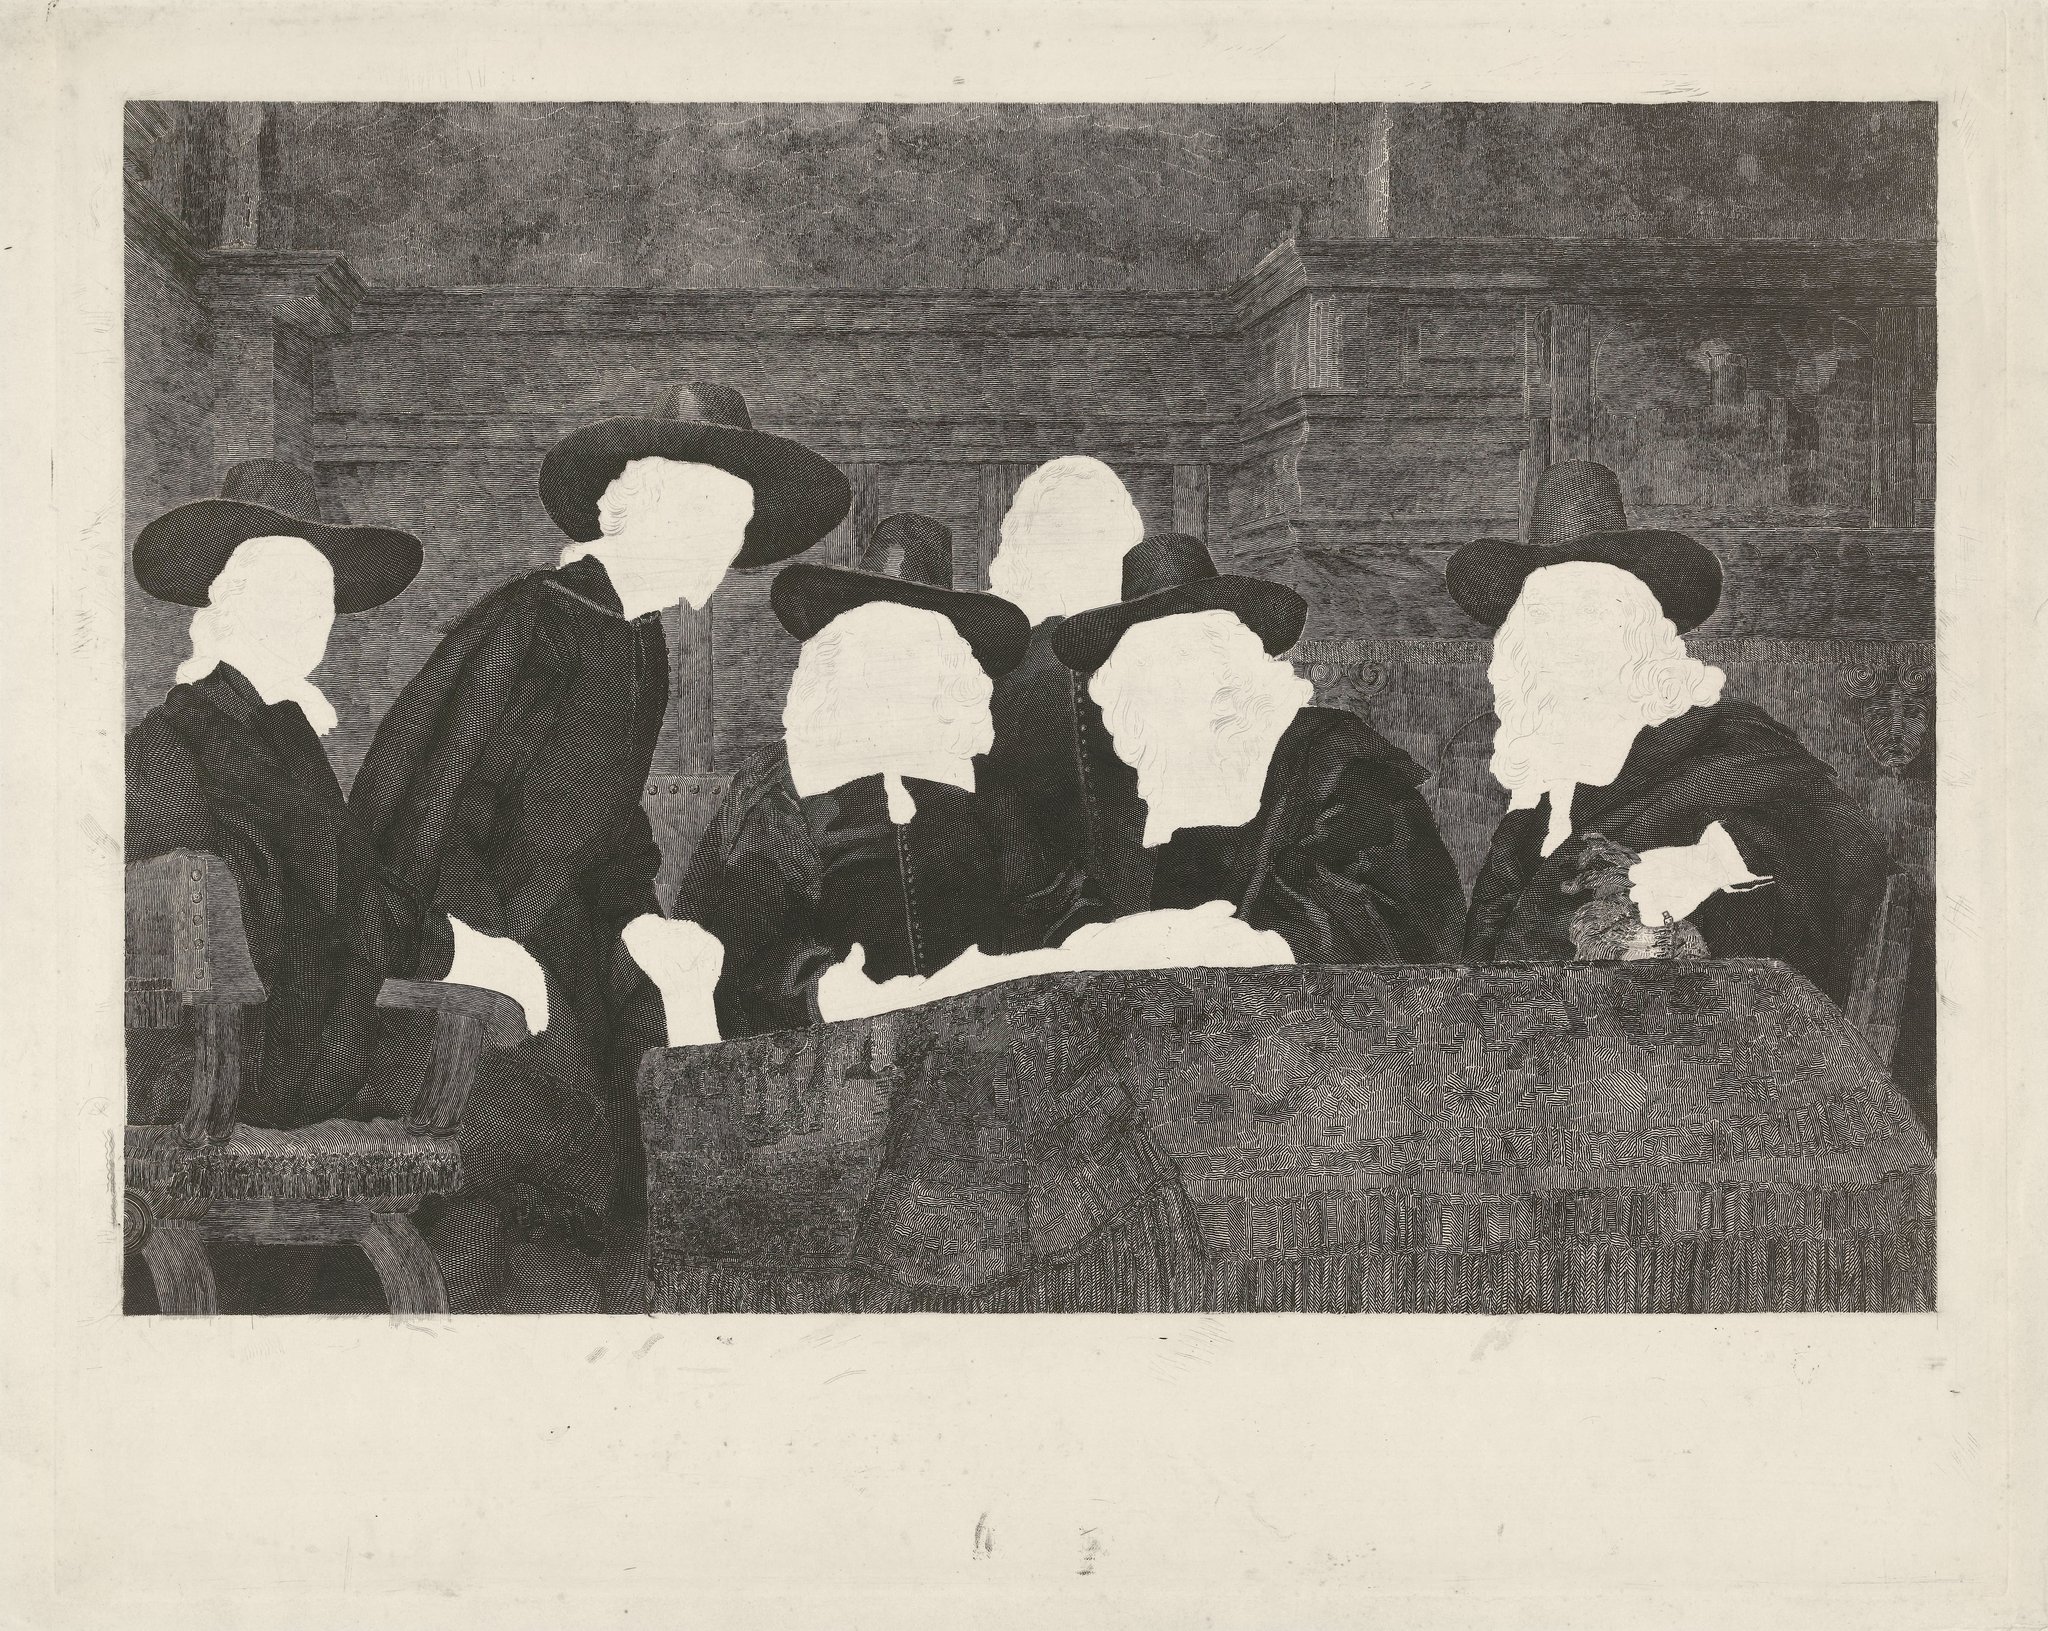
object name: print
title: De waardijns van het Amsterdamse lakenbereidersgilde, bekend als ‘De Staalmeesters’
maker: henricus wilhelmus couwenberg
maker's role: draughtsman, print maker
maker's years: 1814-1845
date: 1844-1845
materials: paper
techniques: etching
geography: amsterdam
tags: historical persons (+ state-portrait), officers trusted with control of quality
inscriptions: collector's mark: Lugt 2228